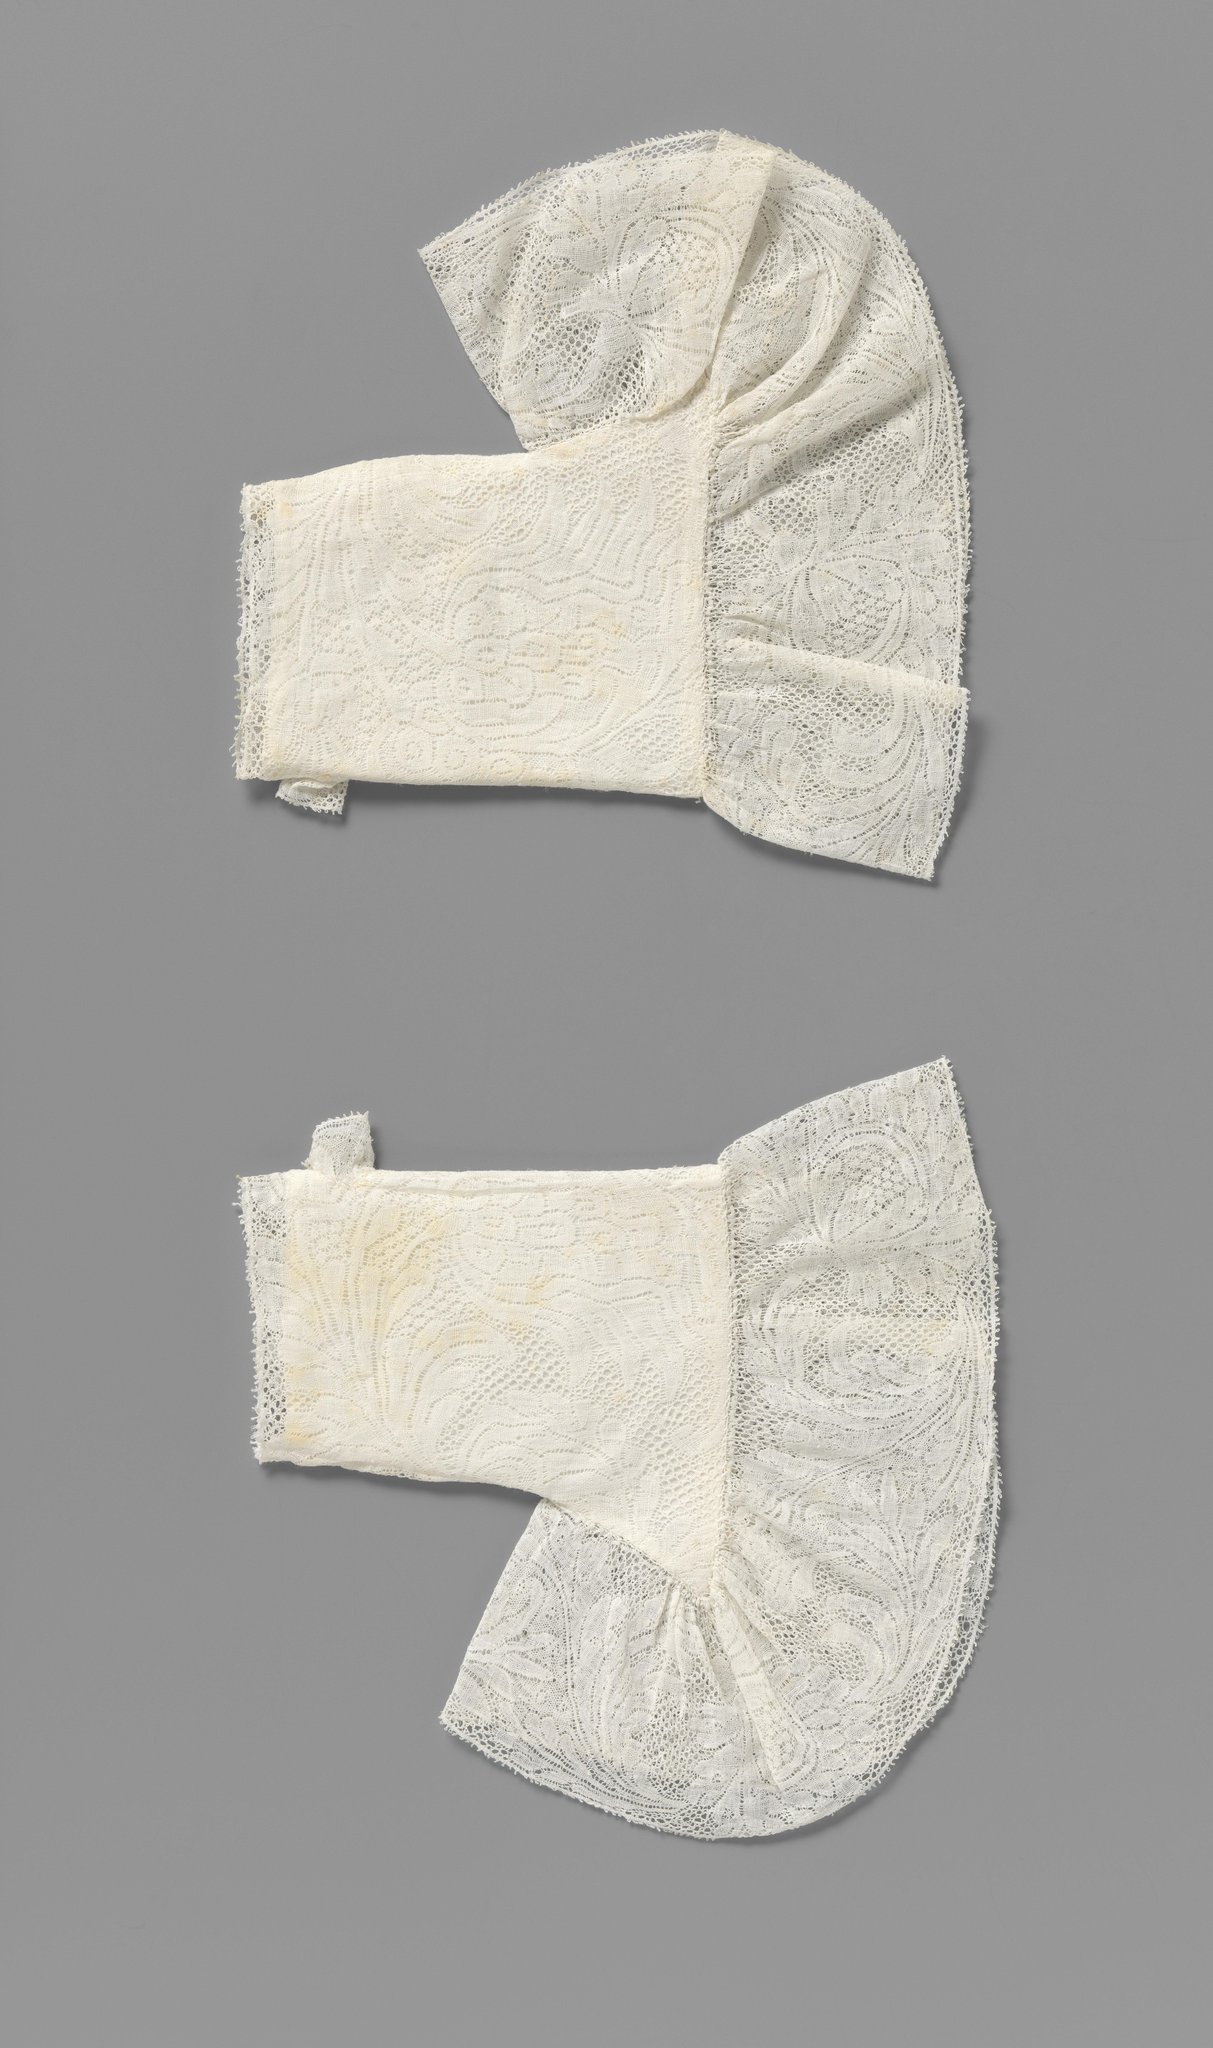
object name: childrenswear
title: Mitaine van Binchekant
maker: Anonymous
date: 1750-1800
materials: linen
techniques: lace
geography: western europe